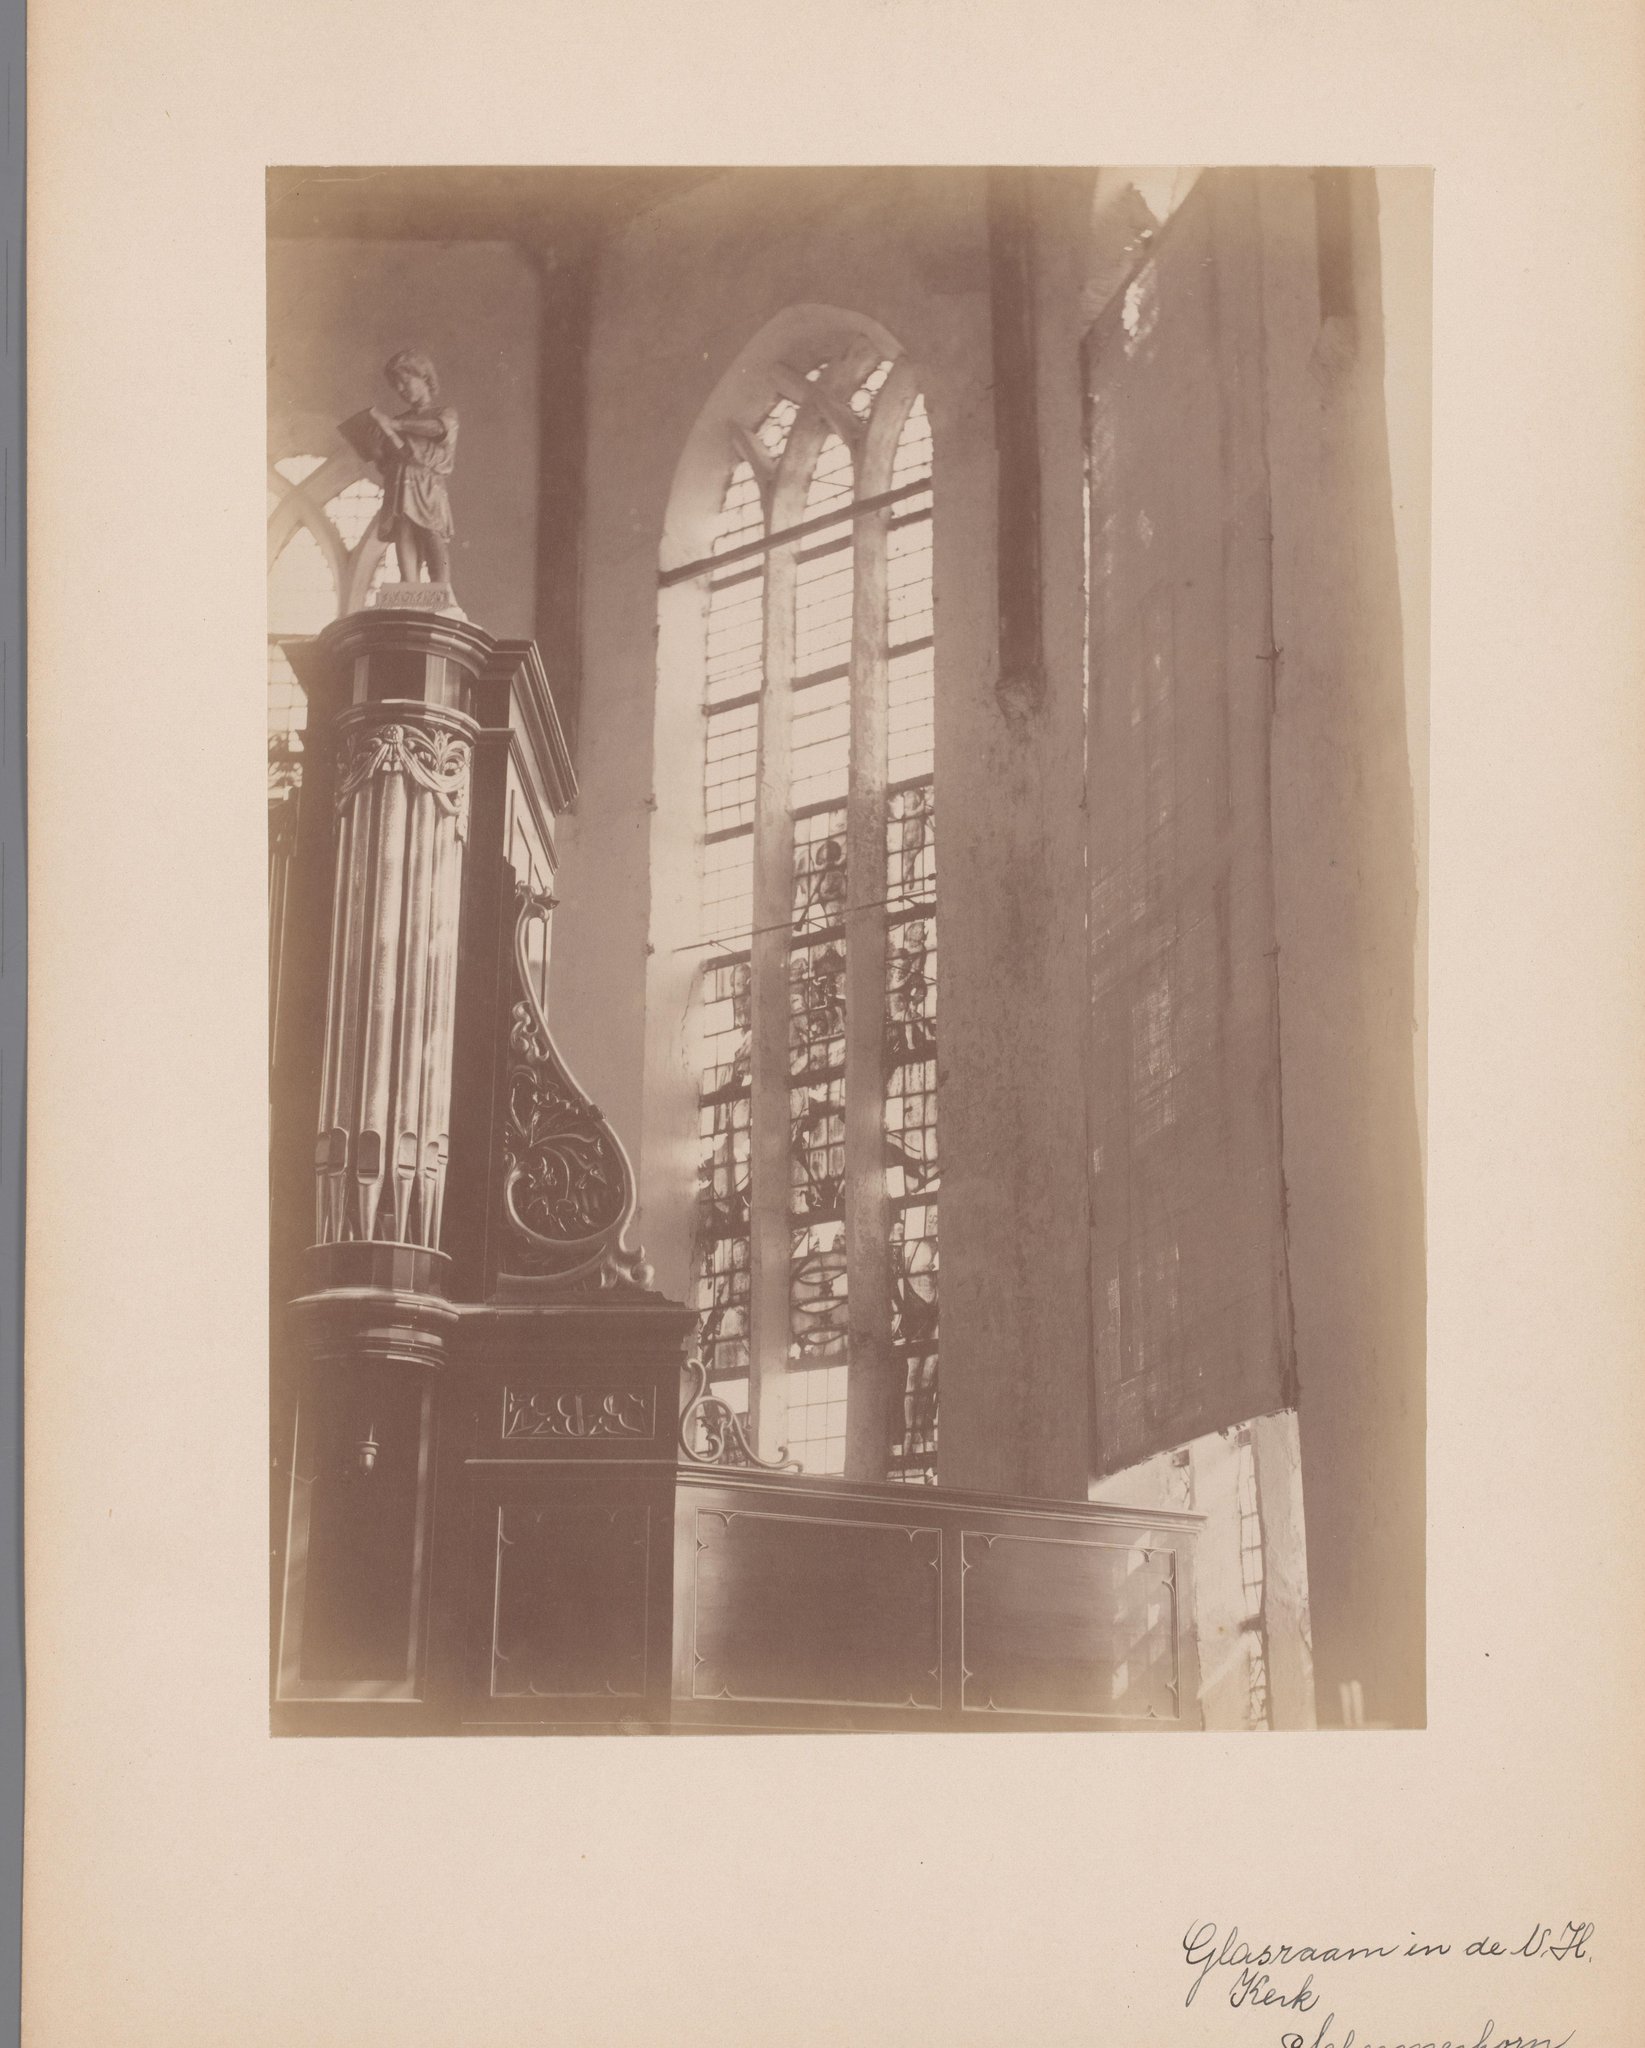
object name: photograph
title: Geschilderd raam in de Grote Kerk te Schermerhorn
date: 1890-1910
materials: cardboard, photographic support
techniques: albumen print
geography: schermerhorn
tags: church-window, e.g. rose-window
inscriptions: annotation: ‘Glasraam in de N.H. Kerk/ Schermerhorn’, annotation: ‘Schermerhorn/ glasraam in de Ned. Herv. Kerk’